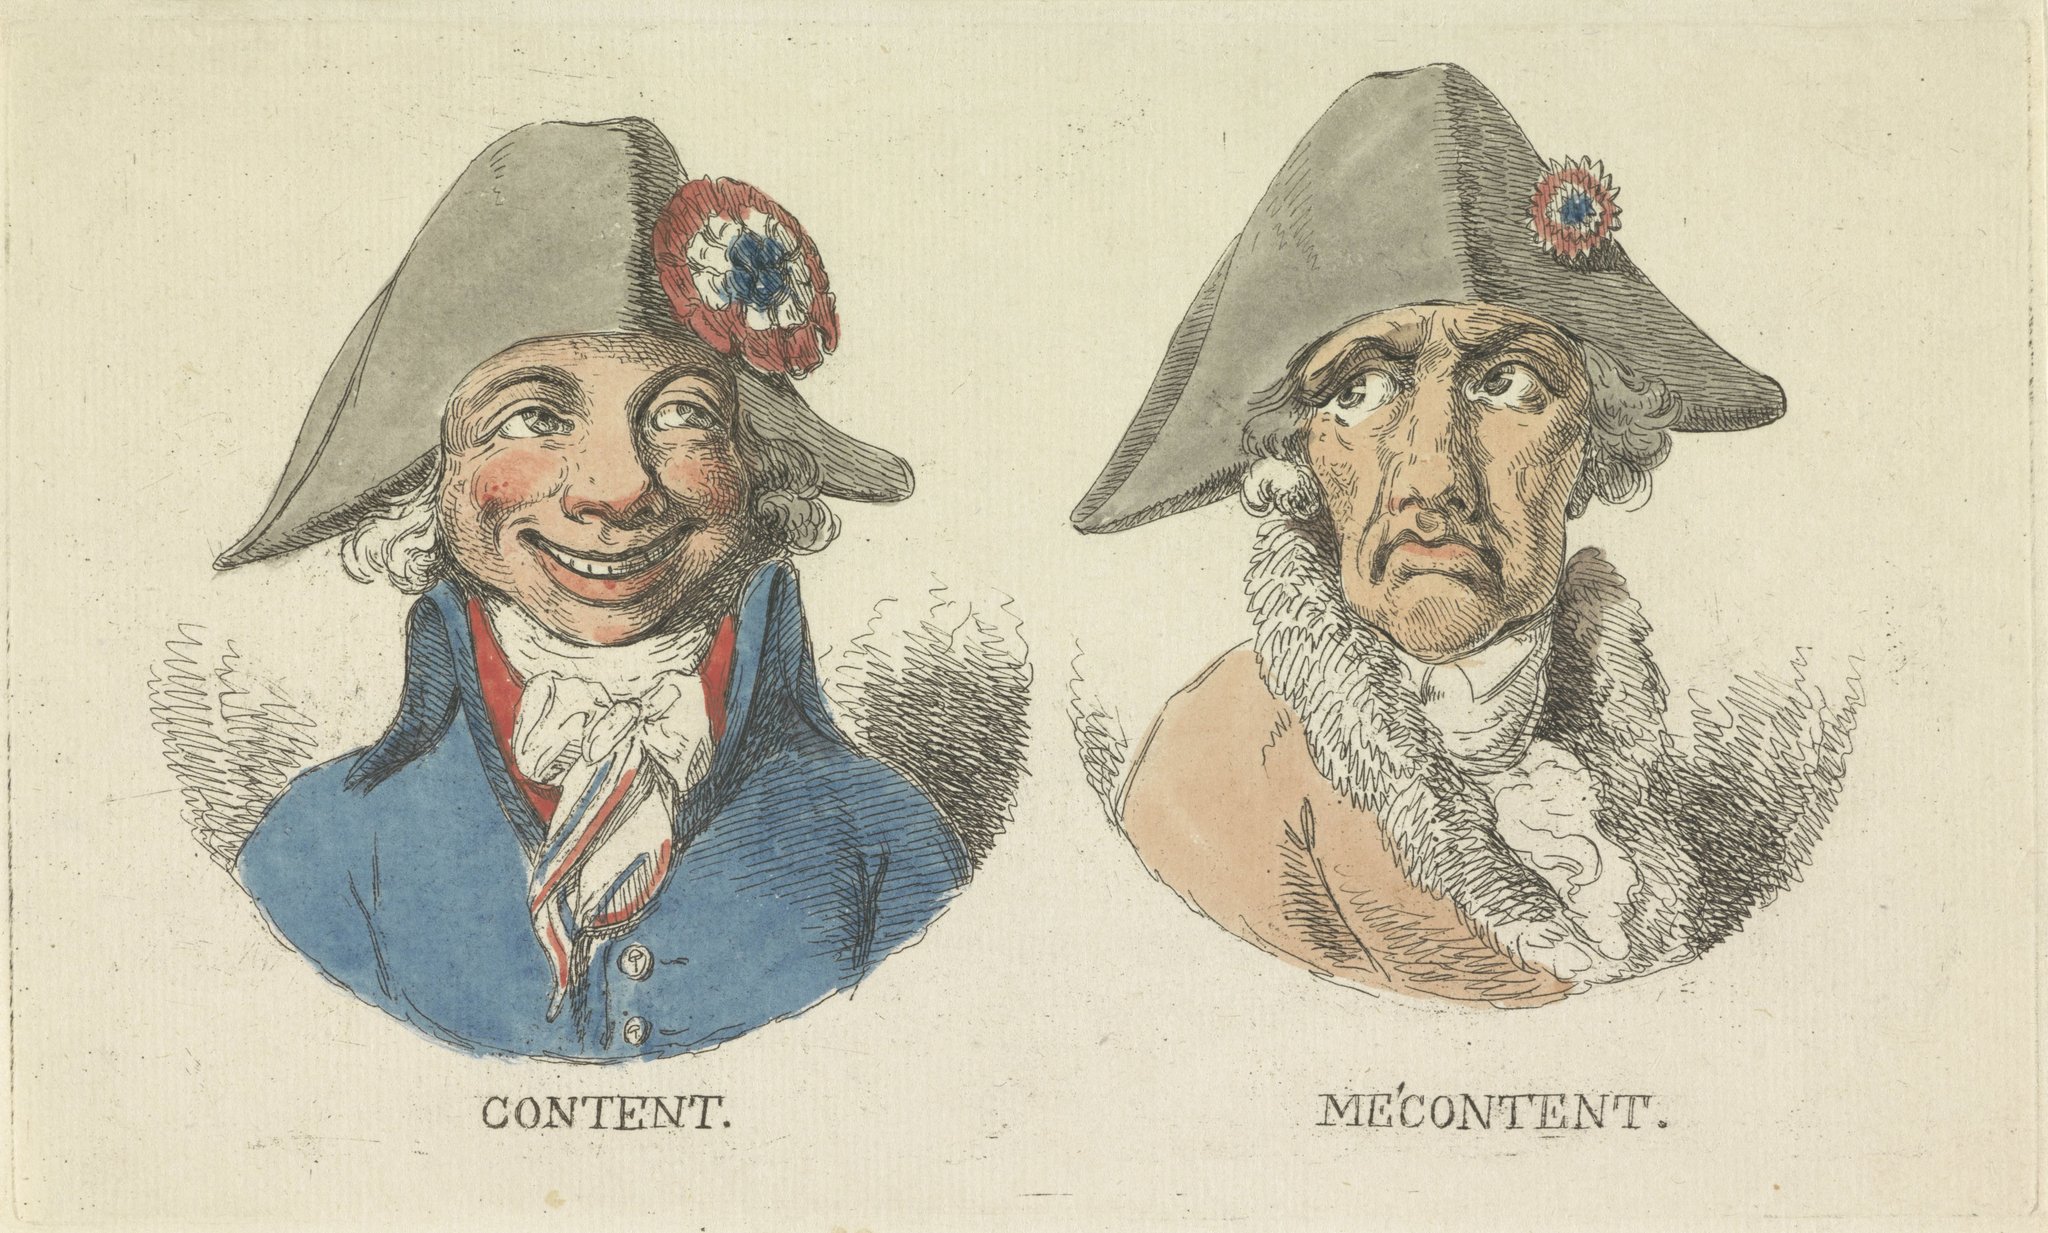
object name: print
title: Tevreden en Ontevreden, 1795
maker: Anonymous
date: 1795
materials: paper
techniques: etching, hand coloring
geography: netherlands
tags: alliance with france (1795)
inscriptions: collector's mark: Lugt 2228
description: Spotprent met twee borstbeelden van mannen die de veranderde politieke verhoudingen in 1795 weergeven. Links de blij en tevreden kijkende man met een Patriots kokarde, rechts de ongelukkig en ontevreden kijkende man met een Oranje kokarde.